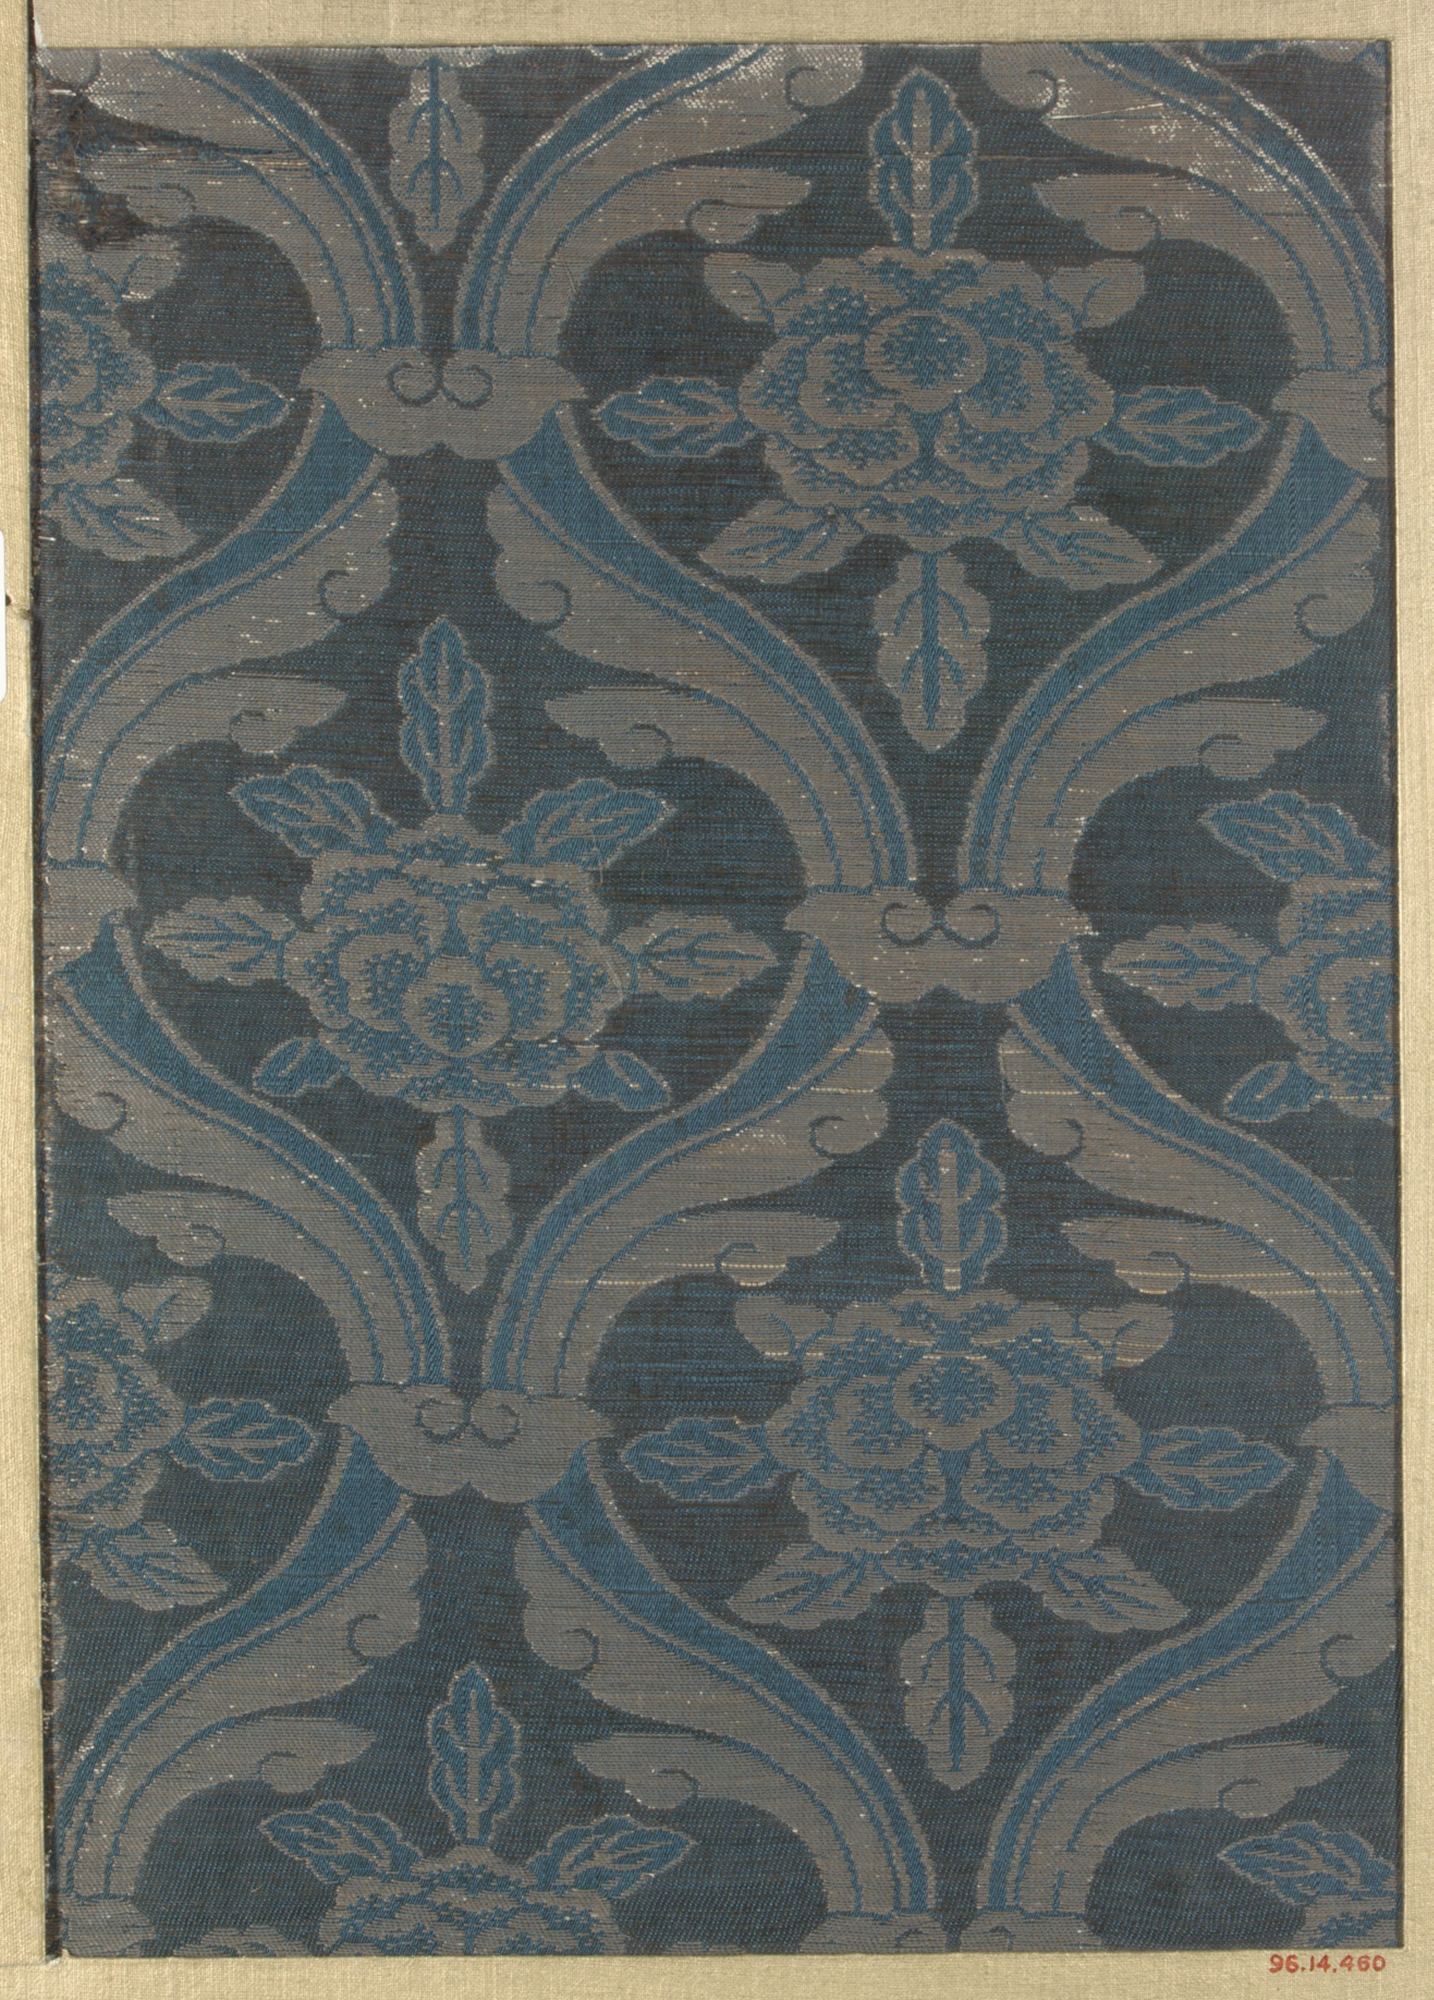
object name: piece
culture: japanese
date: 1701-1900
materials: silk